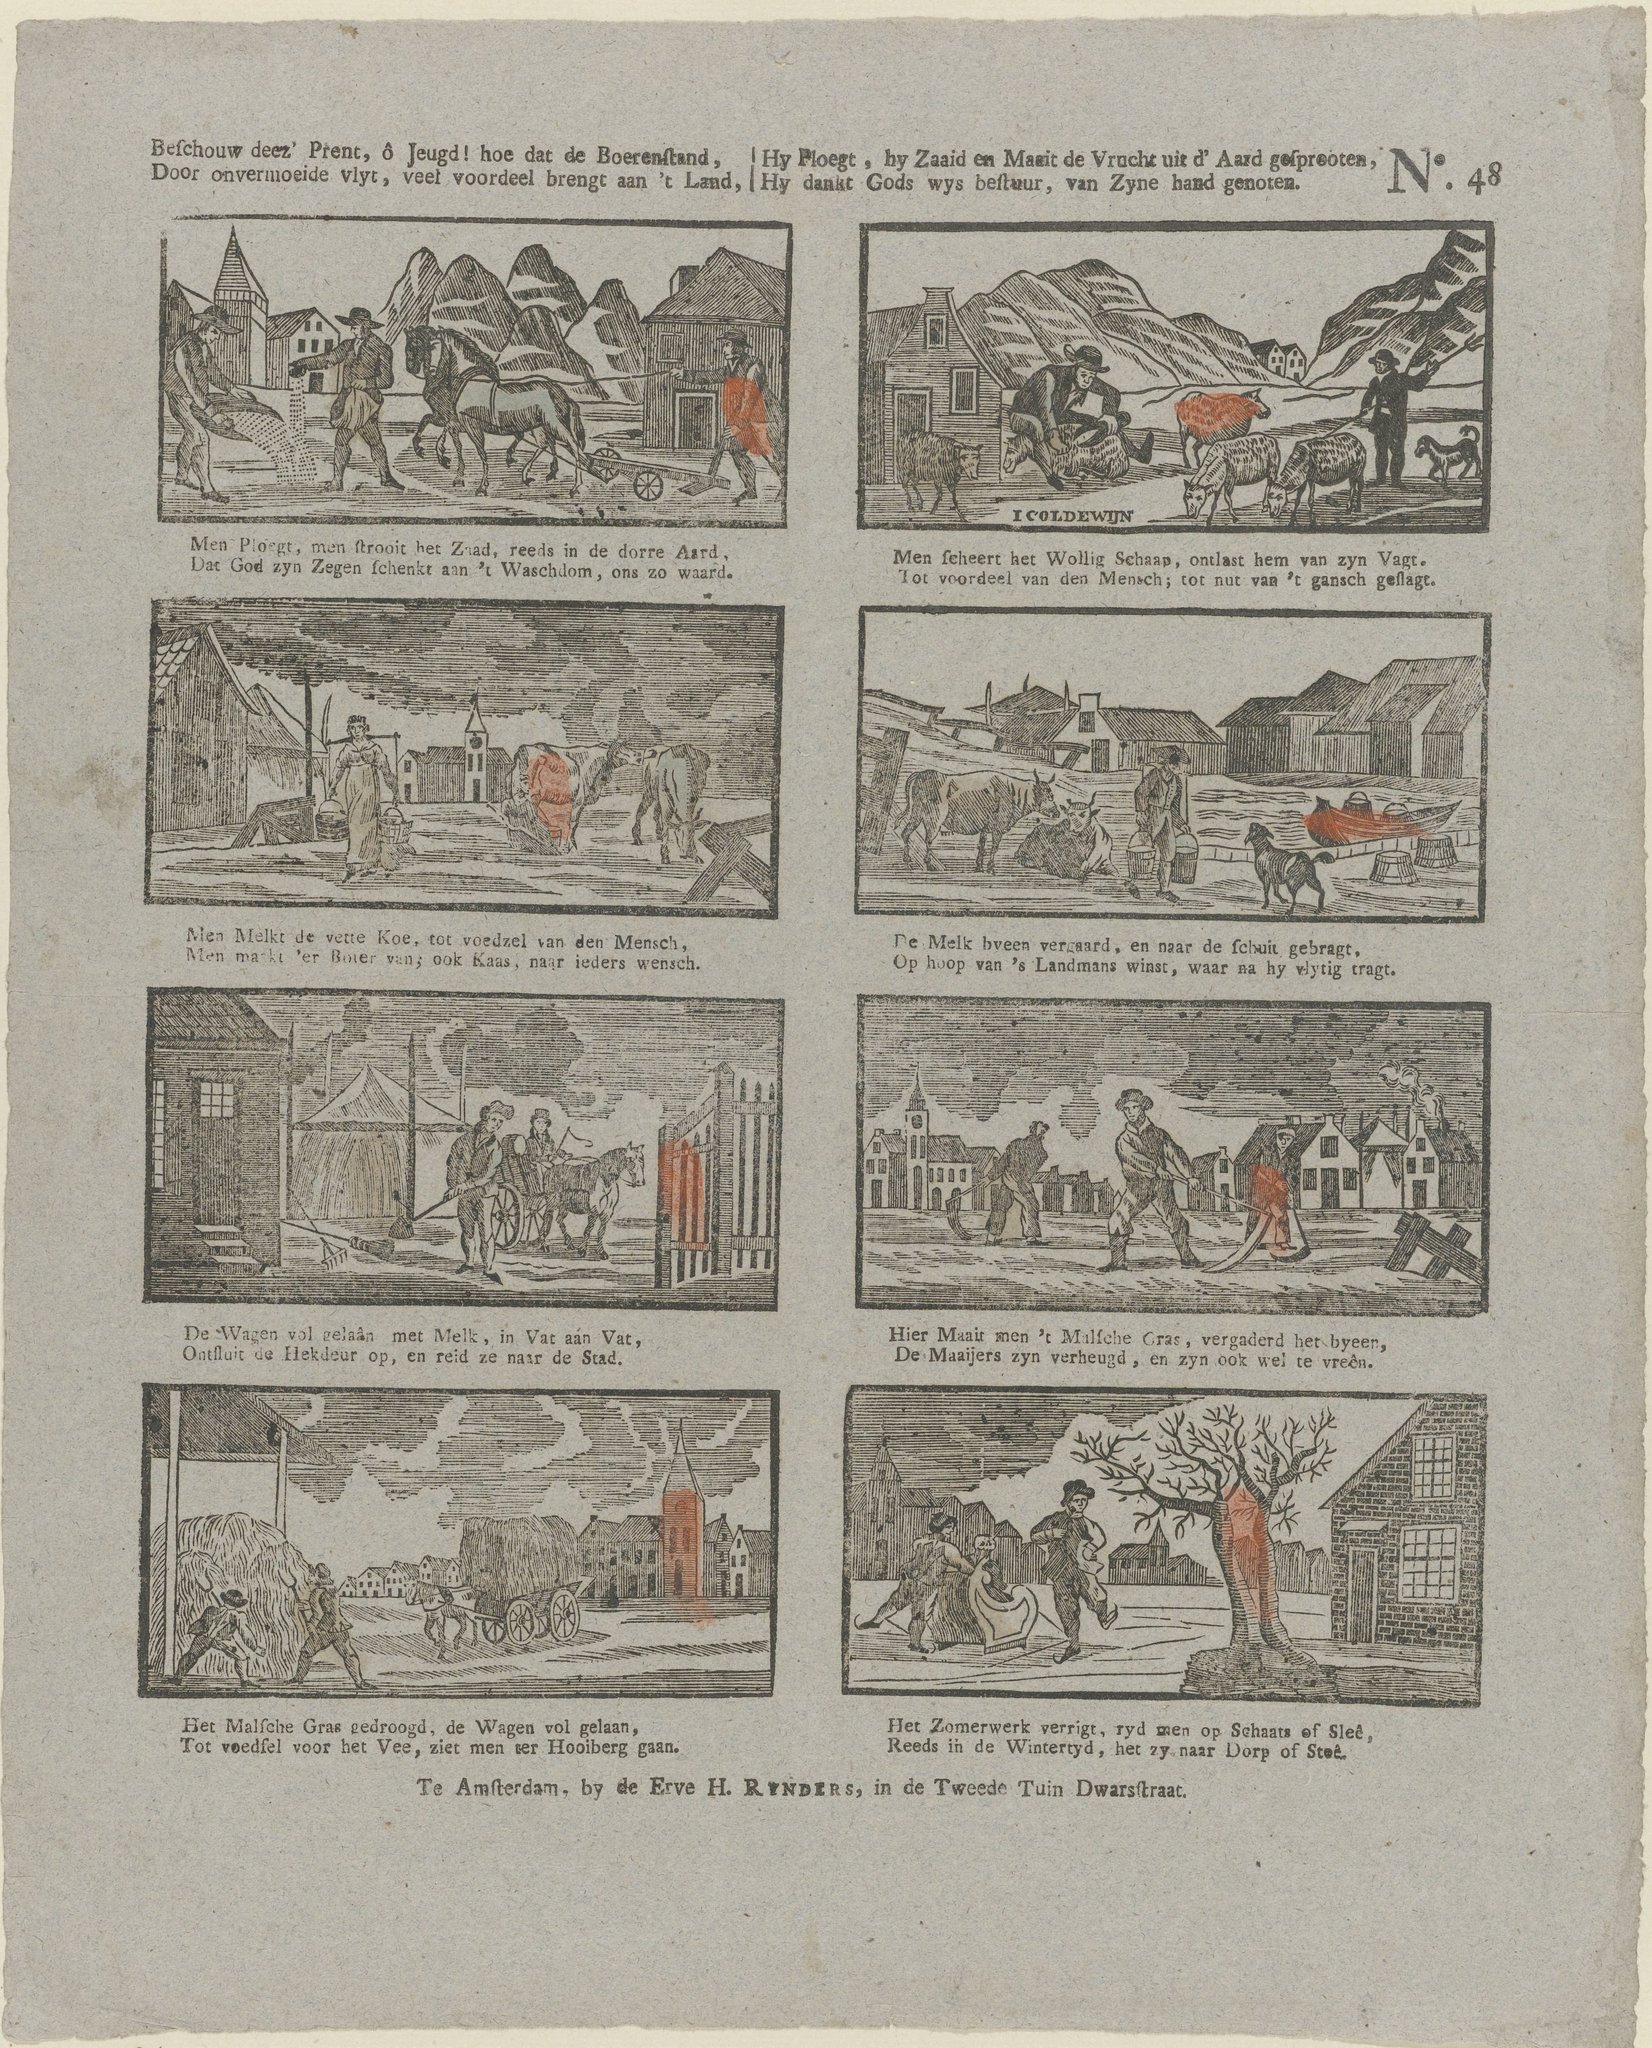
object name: popular print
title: Beschouw deez' prent, ô jeugd! hoe dat de boerenstand, / Door onvermoeide vlyt, veel voordeel brengt aan 't land, / Hy ploegt, hy zaaid en maait de vrucht uit d' Aard gesprooten, / Hy dankt Gods wys bestuur, van zyne hand genoten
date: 1831-1854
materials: paper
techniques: colour, letterpress printing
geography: netherlands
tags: cattle, farmers, agricultural implements, agriculture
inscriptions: collector's mark: Lugt 2760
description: Blad met 8 voorstellingen van werkende boeren en boerinnen. Onder elke afbeelding een tweeregelig vers. Genummerd rechtsboven: No. 48.